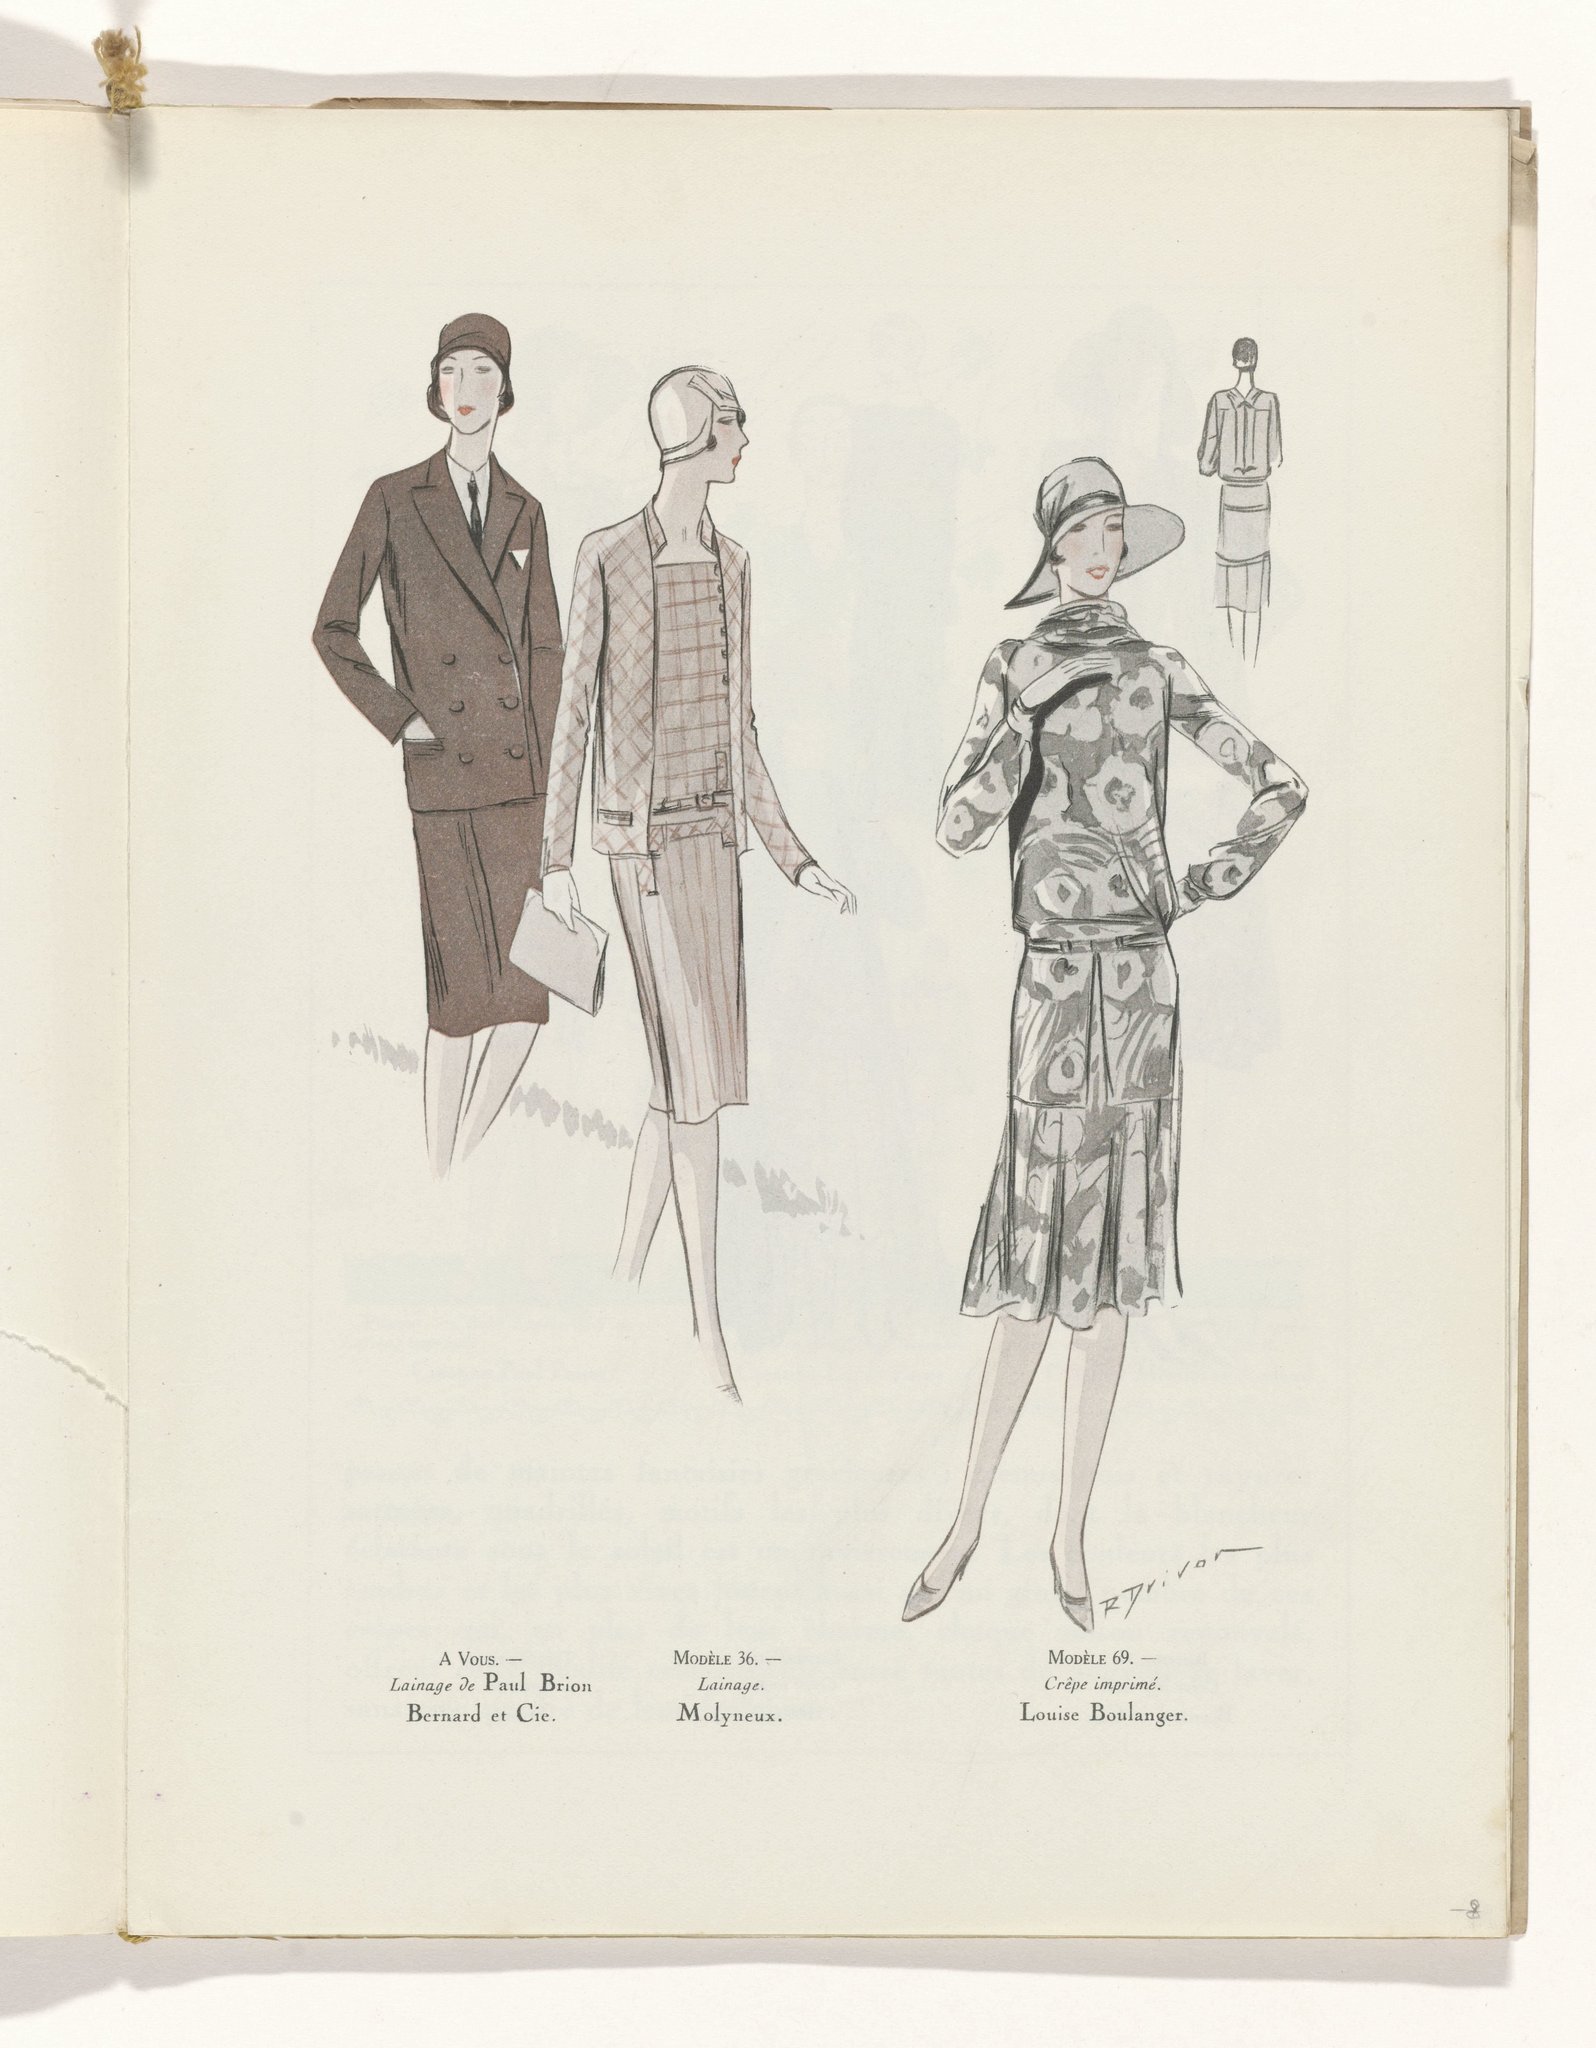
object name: fashion print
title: Art - Goût - Beauté, Feuillets de l' élégance féminine, Juin 1929, No. 106, 9e Année, p.8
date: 1929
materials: paper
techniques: printing, photography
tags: bag (handbag) (+ women's clothes), neck-gear ~ clothing (tie) (+ women's clothes), fashion plates, head-gear: hat (+ women's clothes), skirt (+ women's clothes), dress, gown (+ women's clothes)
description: Drie ensembles van Bernard et Cie, Molyneux en Louise Boulange. Pagina uit het modetijdschrift Art-Goût-Beauté (1920-1933).